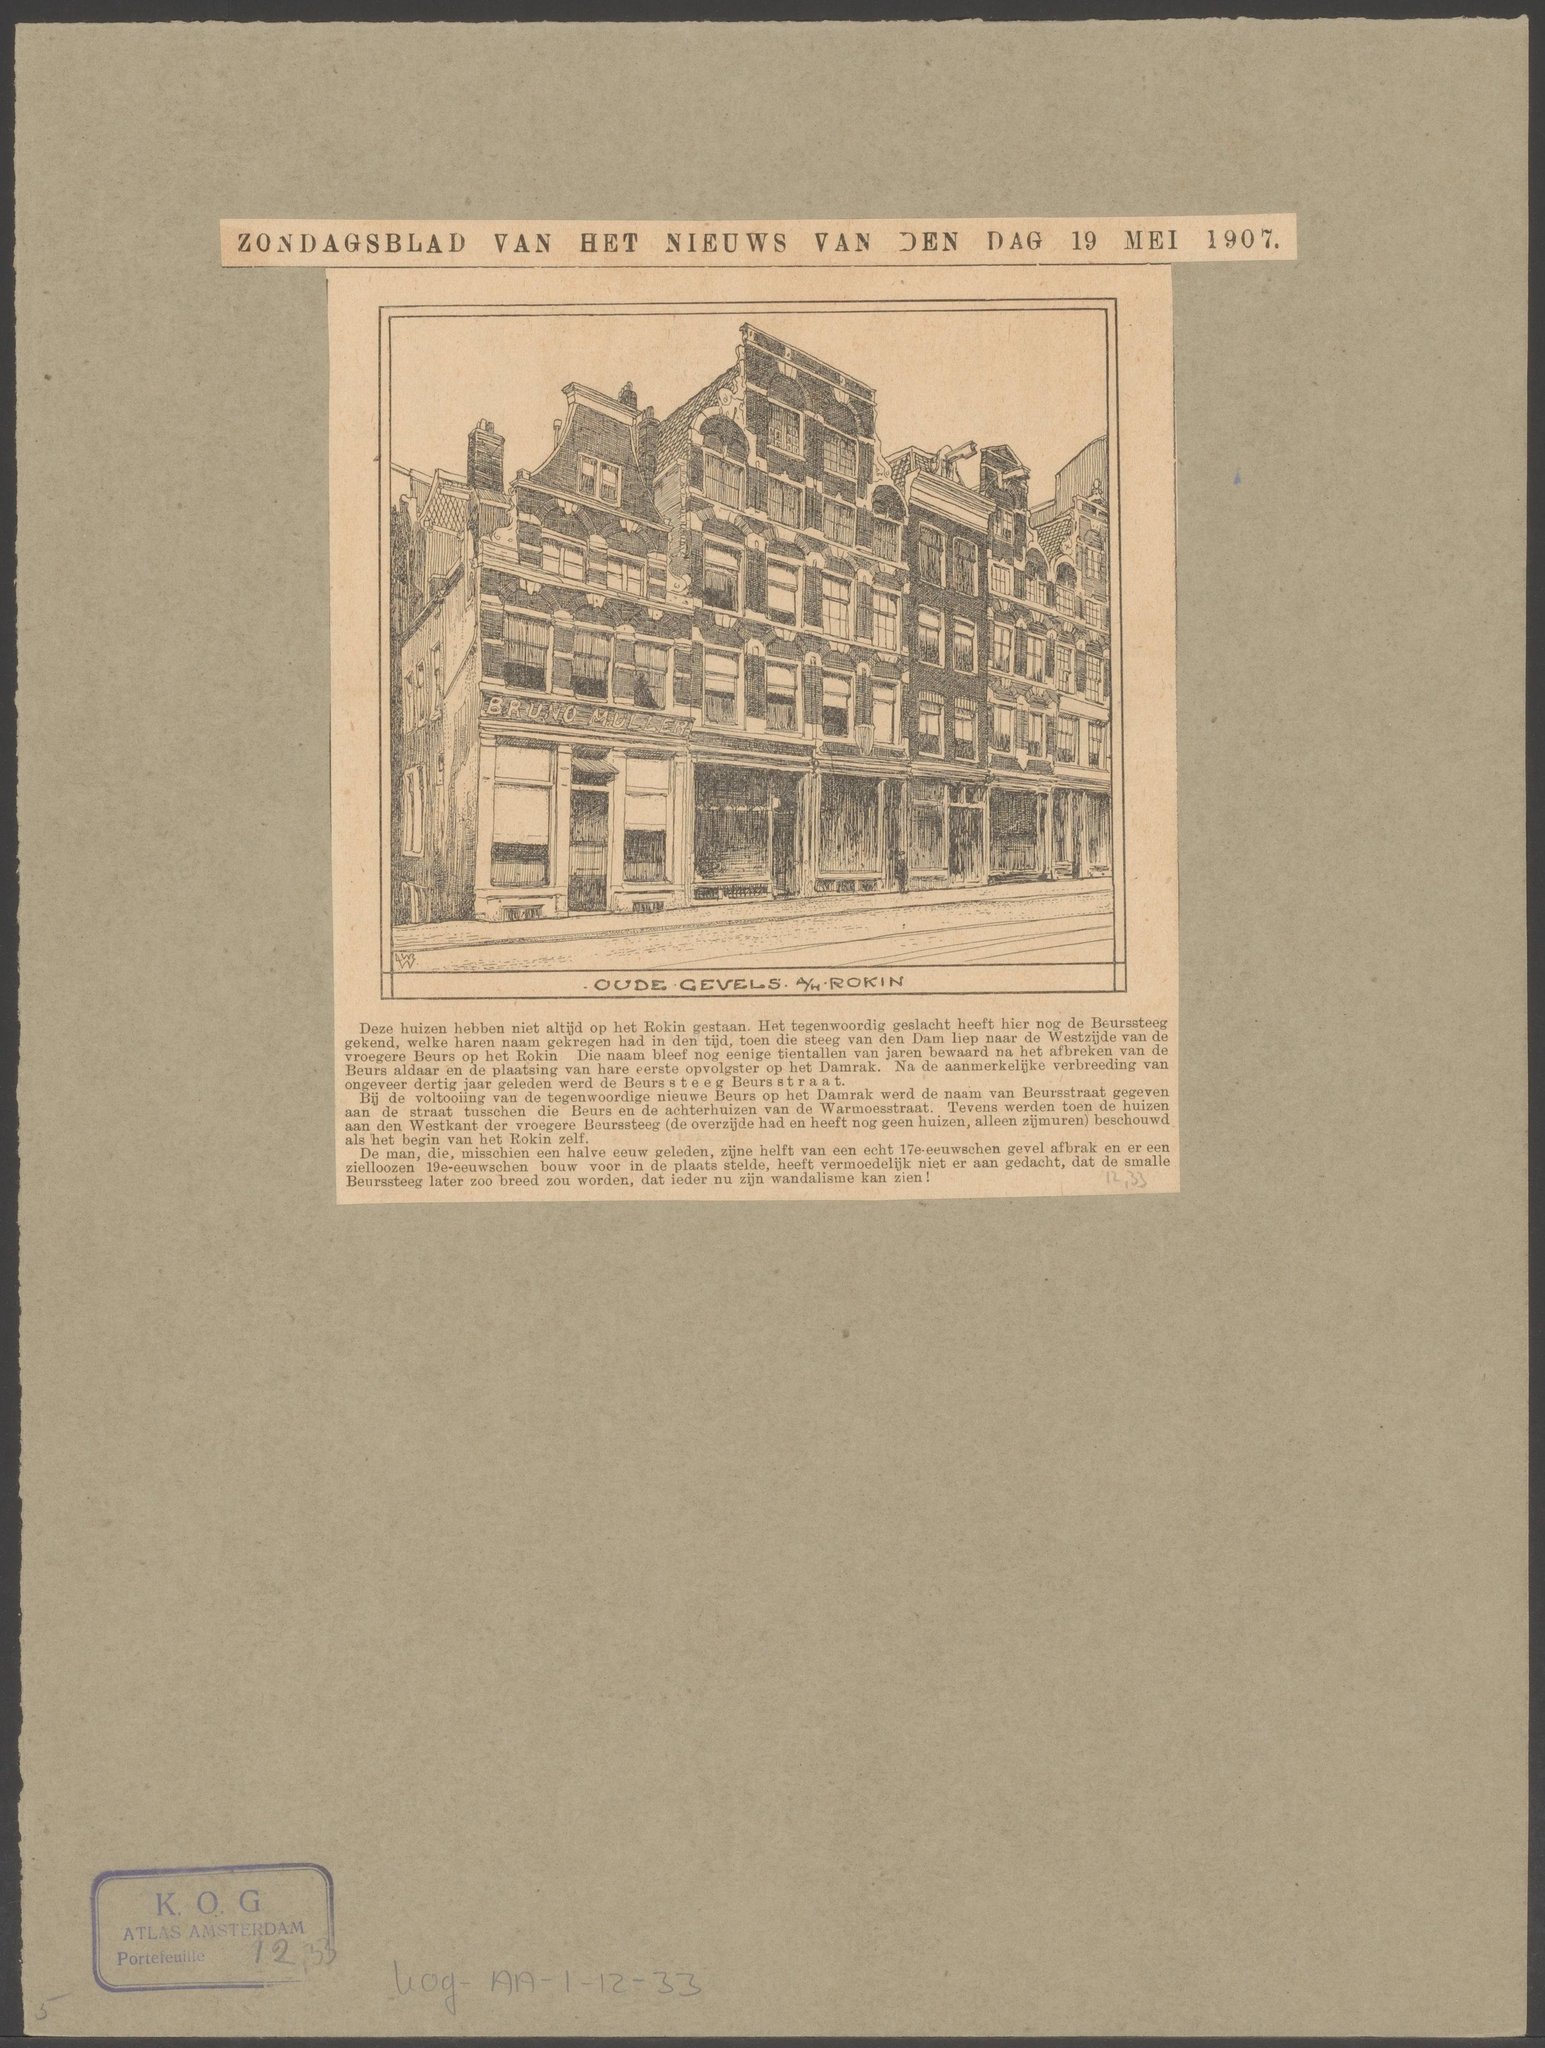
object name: photomechanical print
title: Gezicht op enkele gevels aan het Rokin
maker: willem wenckebach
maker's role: designer, draughtsman, painter, print maker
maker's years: 1860-1937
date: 1907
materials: paper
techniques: letterpress printing, line block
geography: amsterdam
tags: city-view in general; 'veduta', the usual house or row of houses, façade (of house or building), street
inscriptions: collector's mark: ‘12,33’ Lugt 1641b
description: Onderwerpsrubriek binnen de Atlas Amsterdam: Rokin, Rotterdammersloot, Rozengang, Rozengracht, Rozenstraat, Rusland, Rustenburgerstraat, Ruysdaelkade, Ruysdaelstraat, Ruyterkade (de), Ruyterweg (Admiraal de).